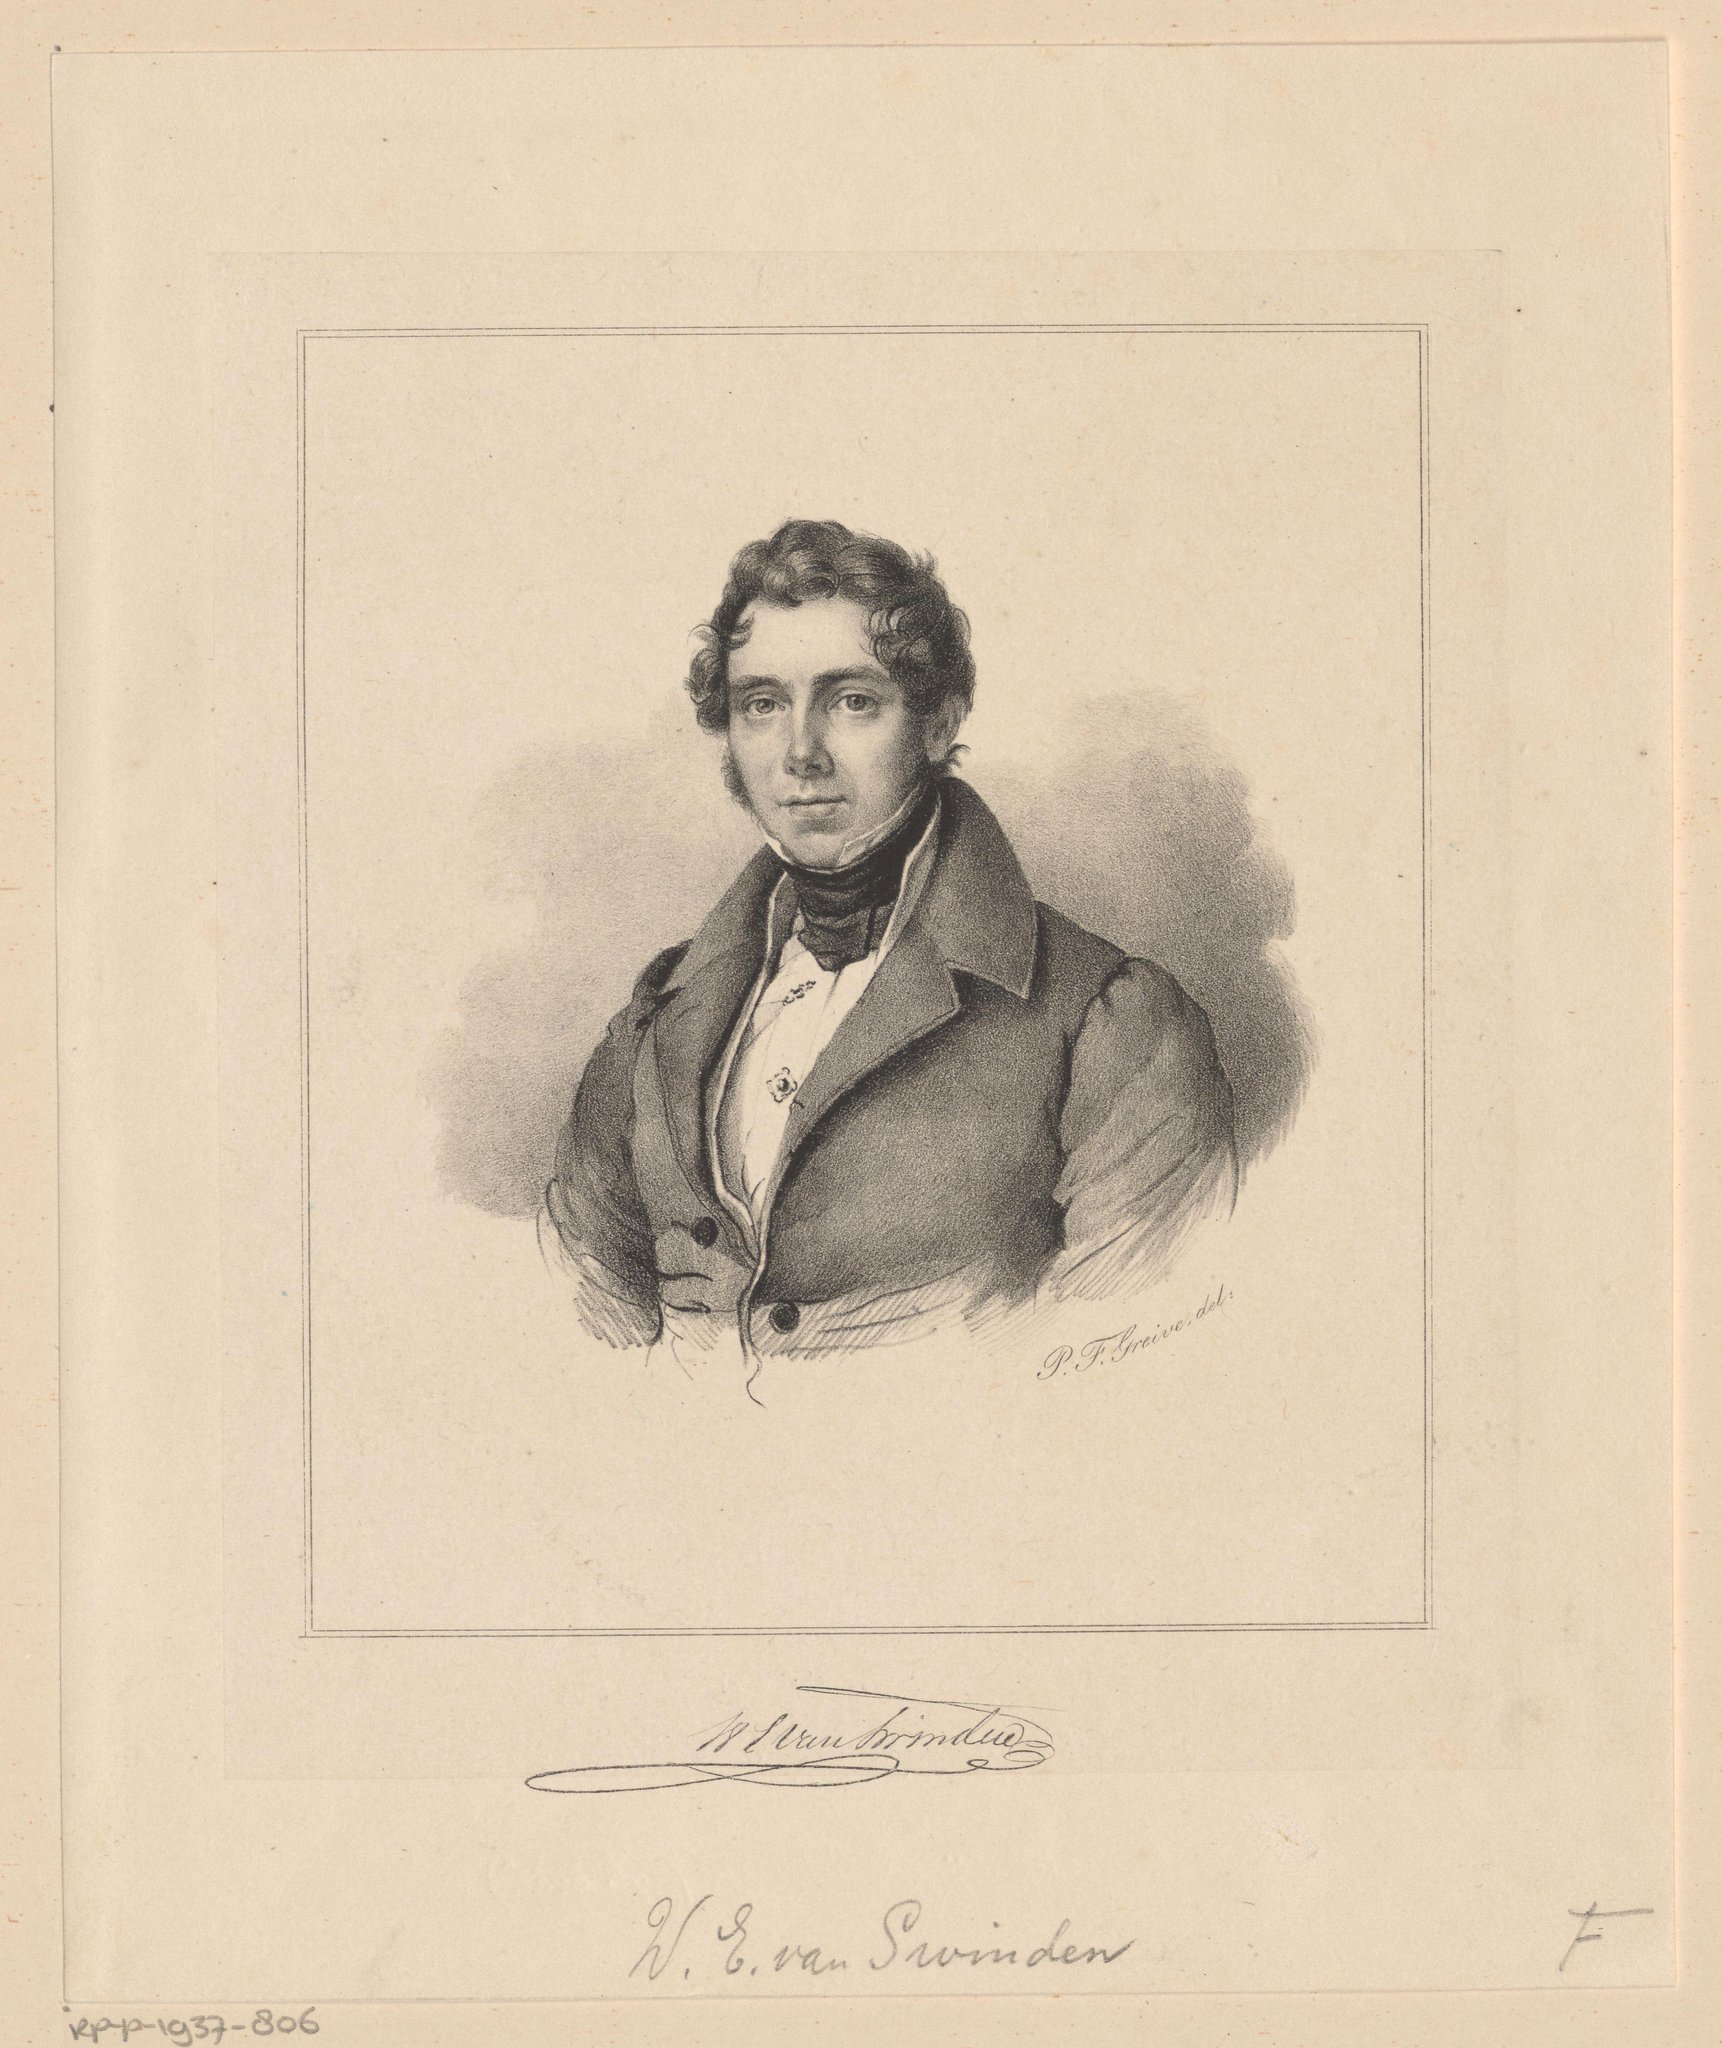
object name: print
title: Portret van Henri Etienne van Swinden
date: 1821-1836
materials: paper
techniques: lithograph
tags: historical persons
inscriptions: collector's mark: Lugt 2228, collector's mark: Lugt 2760